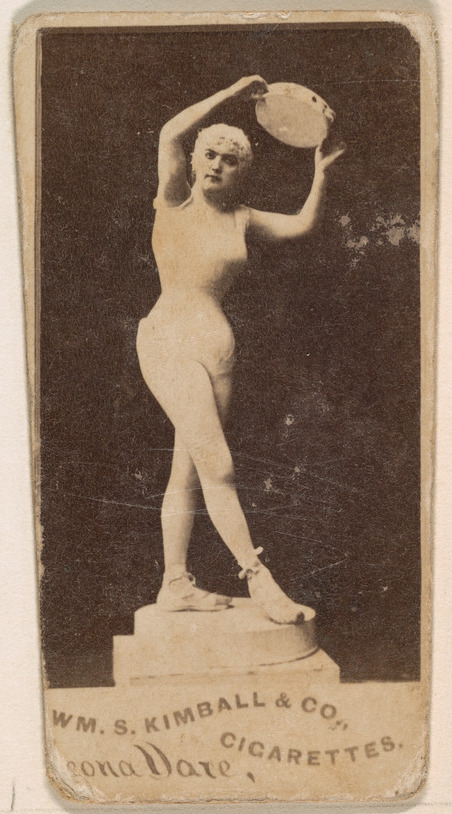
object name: photograph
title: Leona Dare, from the Actresses series (N203) issued by Wm. S. Kimball & Co.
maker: william s. kimball & company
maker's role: publisher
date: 1889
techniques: color lithograph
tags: portraits,women,actresses